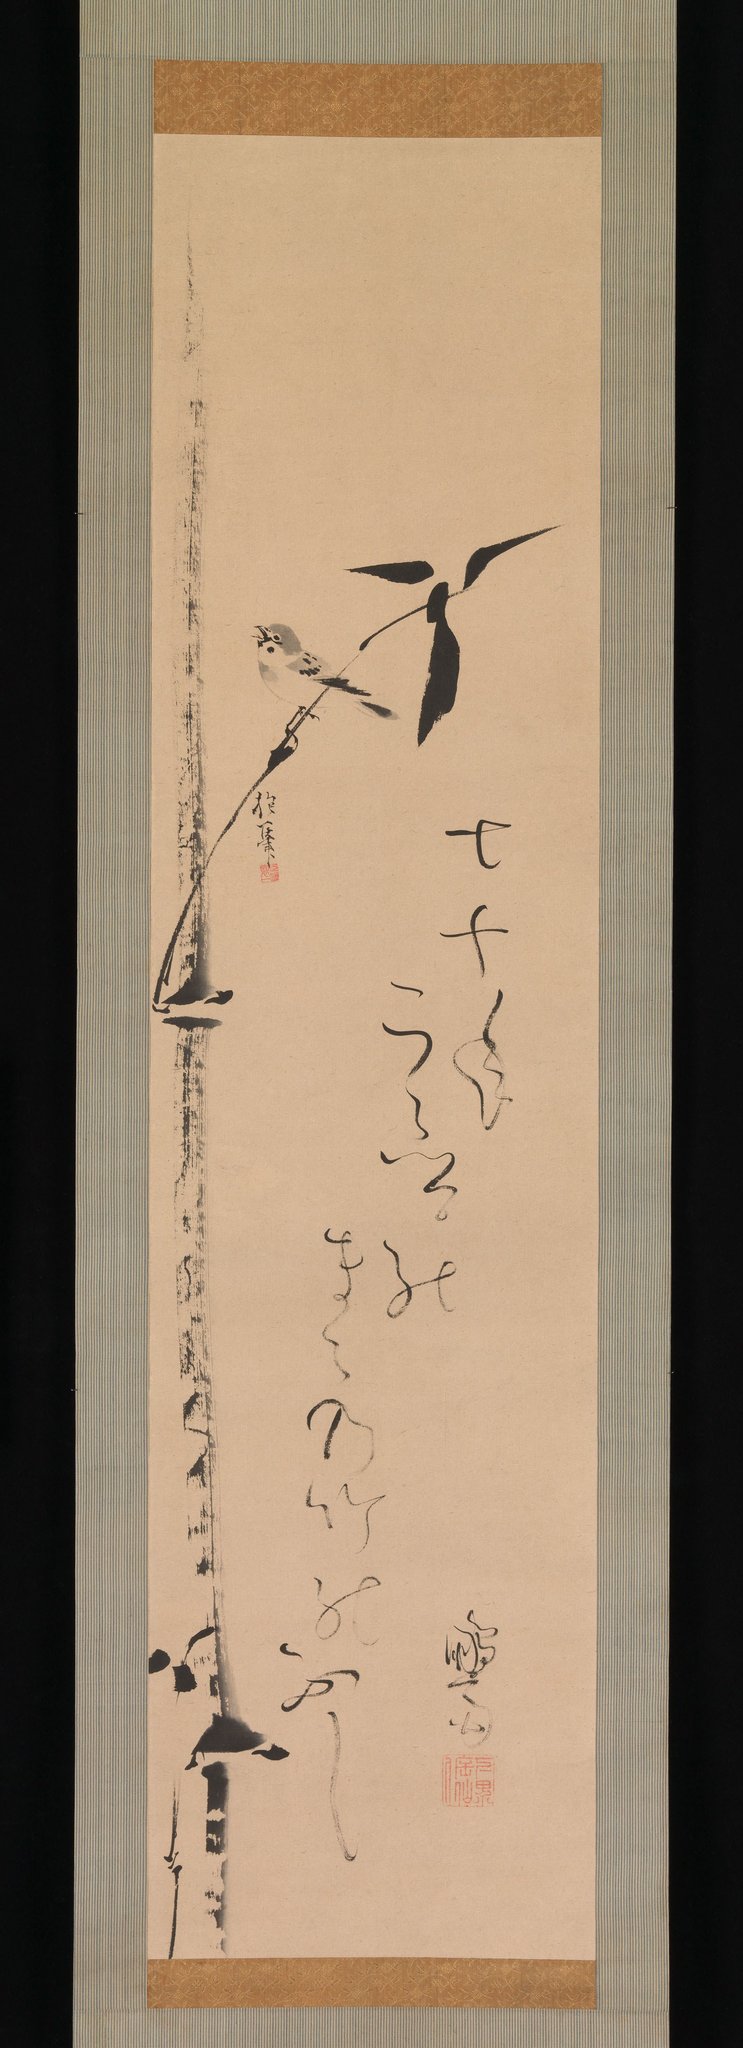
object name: hanging scroll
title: Sparrow and Bamboo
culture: japanese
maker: sakai hōitsu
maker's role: artist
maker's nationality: japanese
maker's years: 1761-1828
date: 1821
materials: ink, paper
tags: birds,bamboo